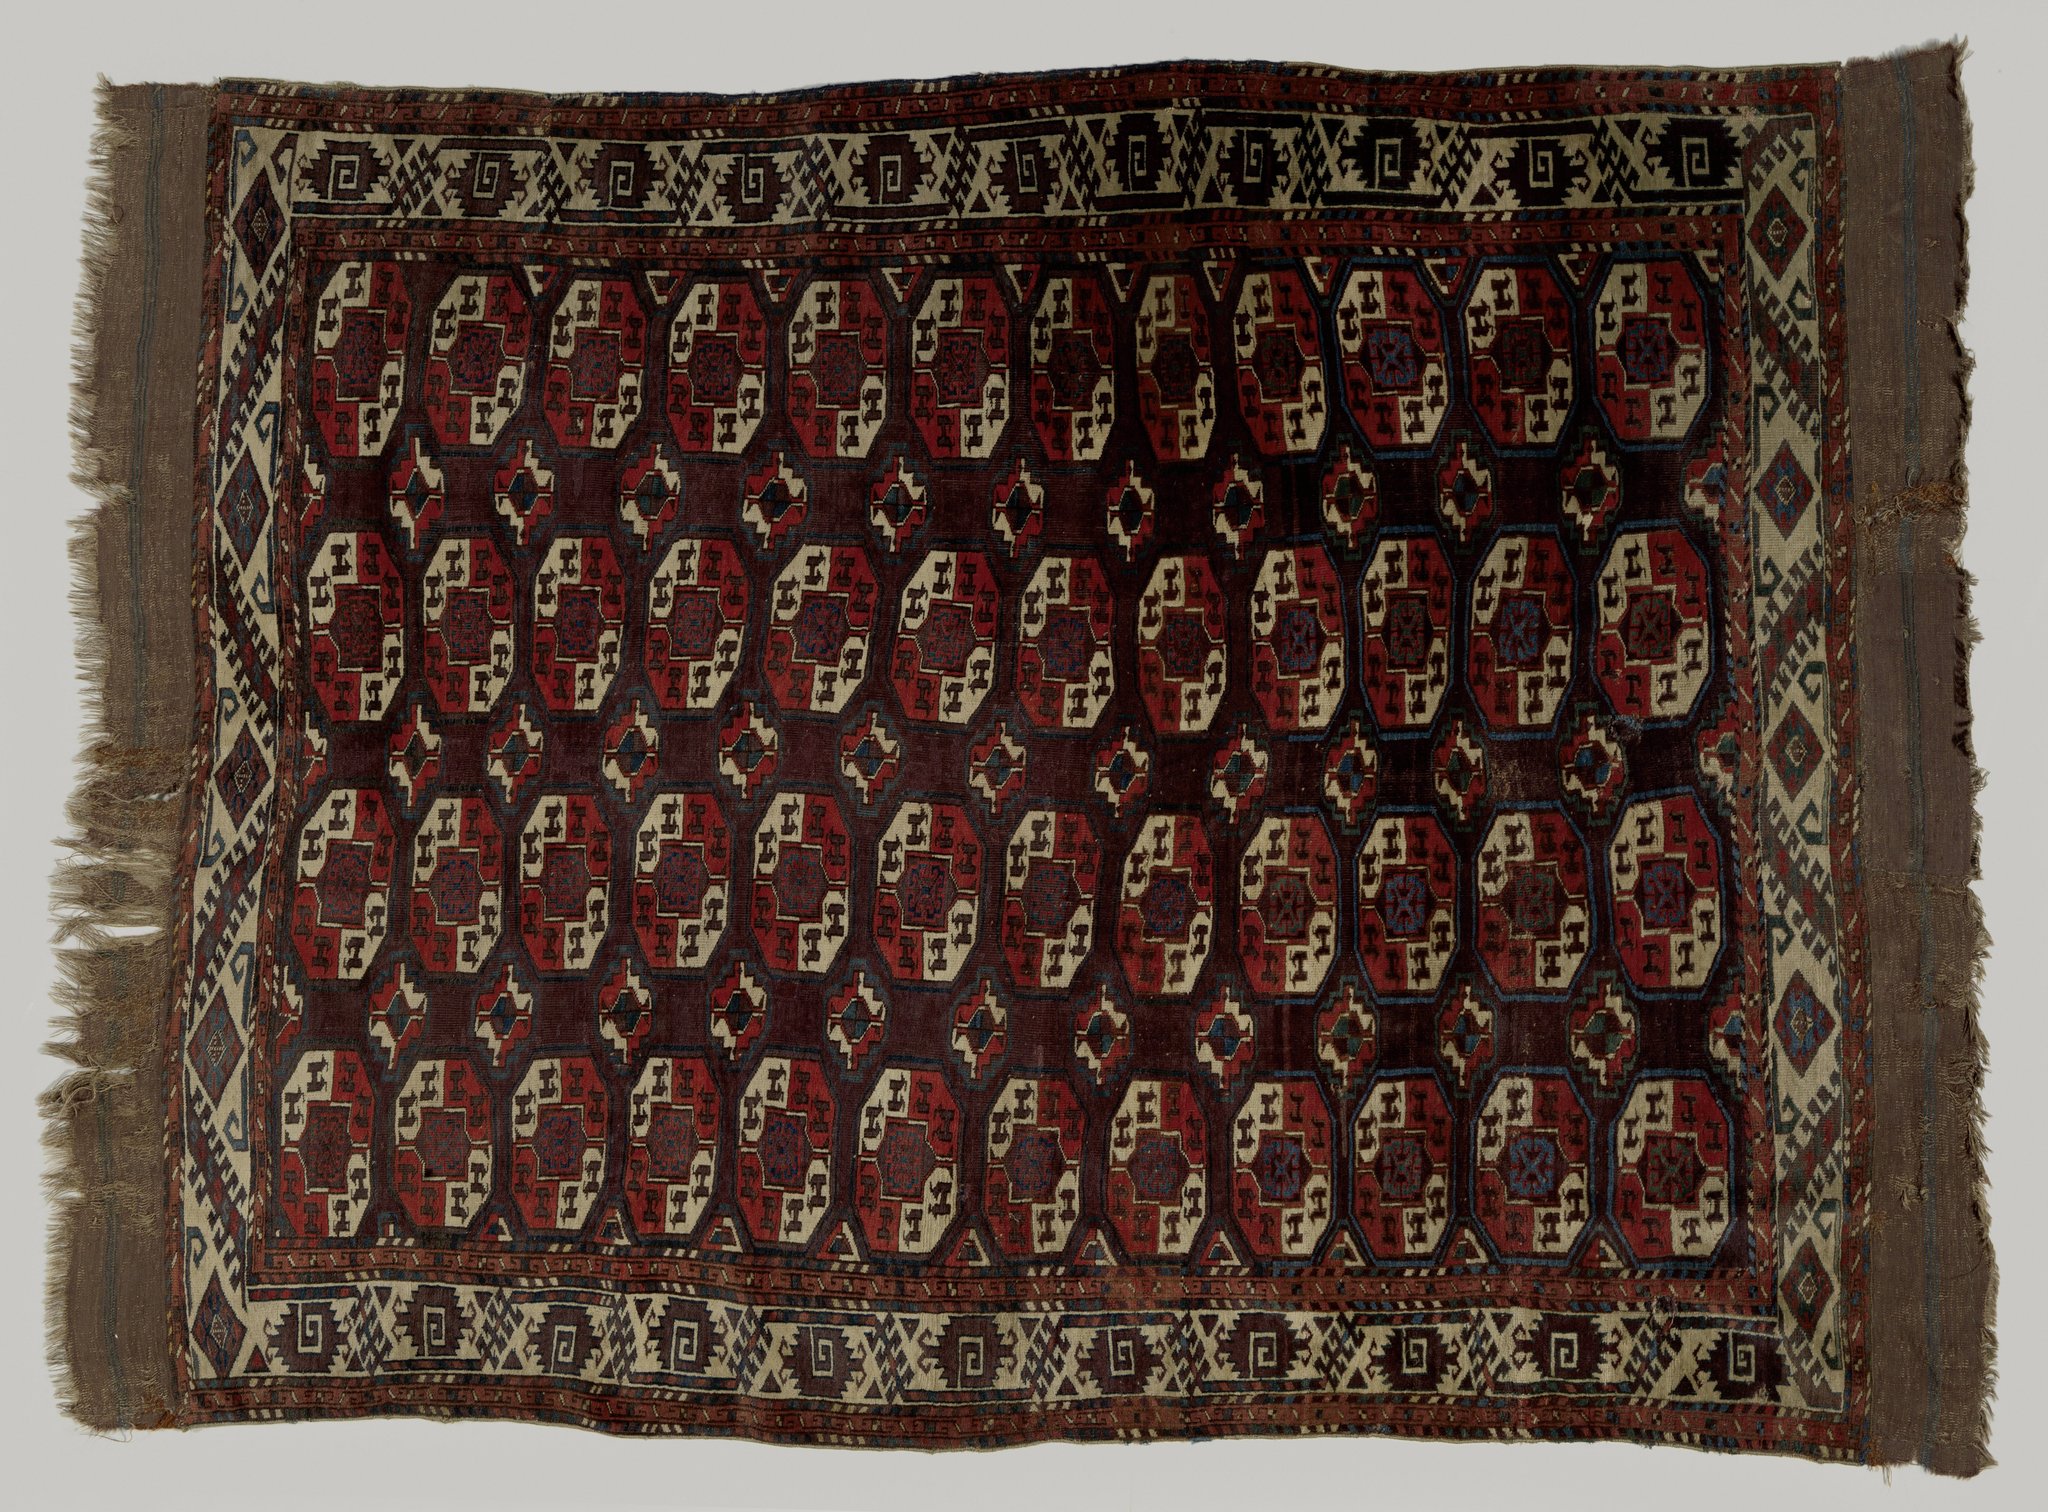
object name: oriental rug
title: Oosters tapijt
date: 1800-1850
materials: wool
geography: central asia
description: Oosters tapijt, achthoekenkleed. Tegen een dieppaars fond staan octagonale "tauk nuska" guls, afgewisseld door chuval guls. De breedste rand is versierd met een gestileerde bladrank.